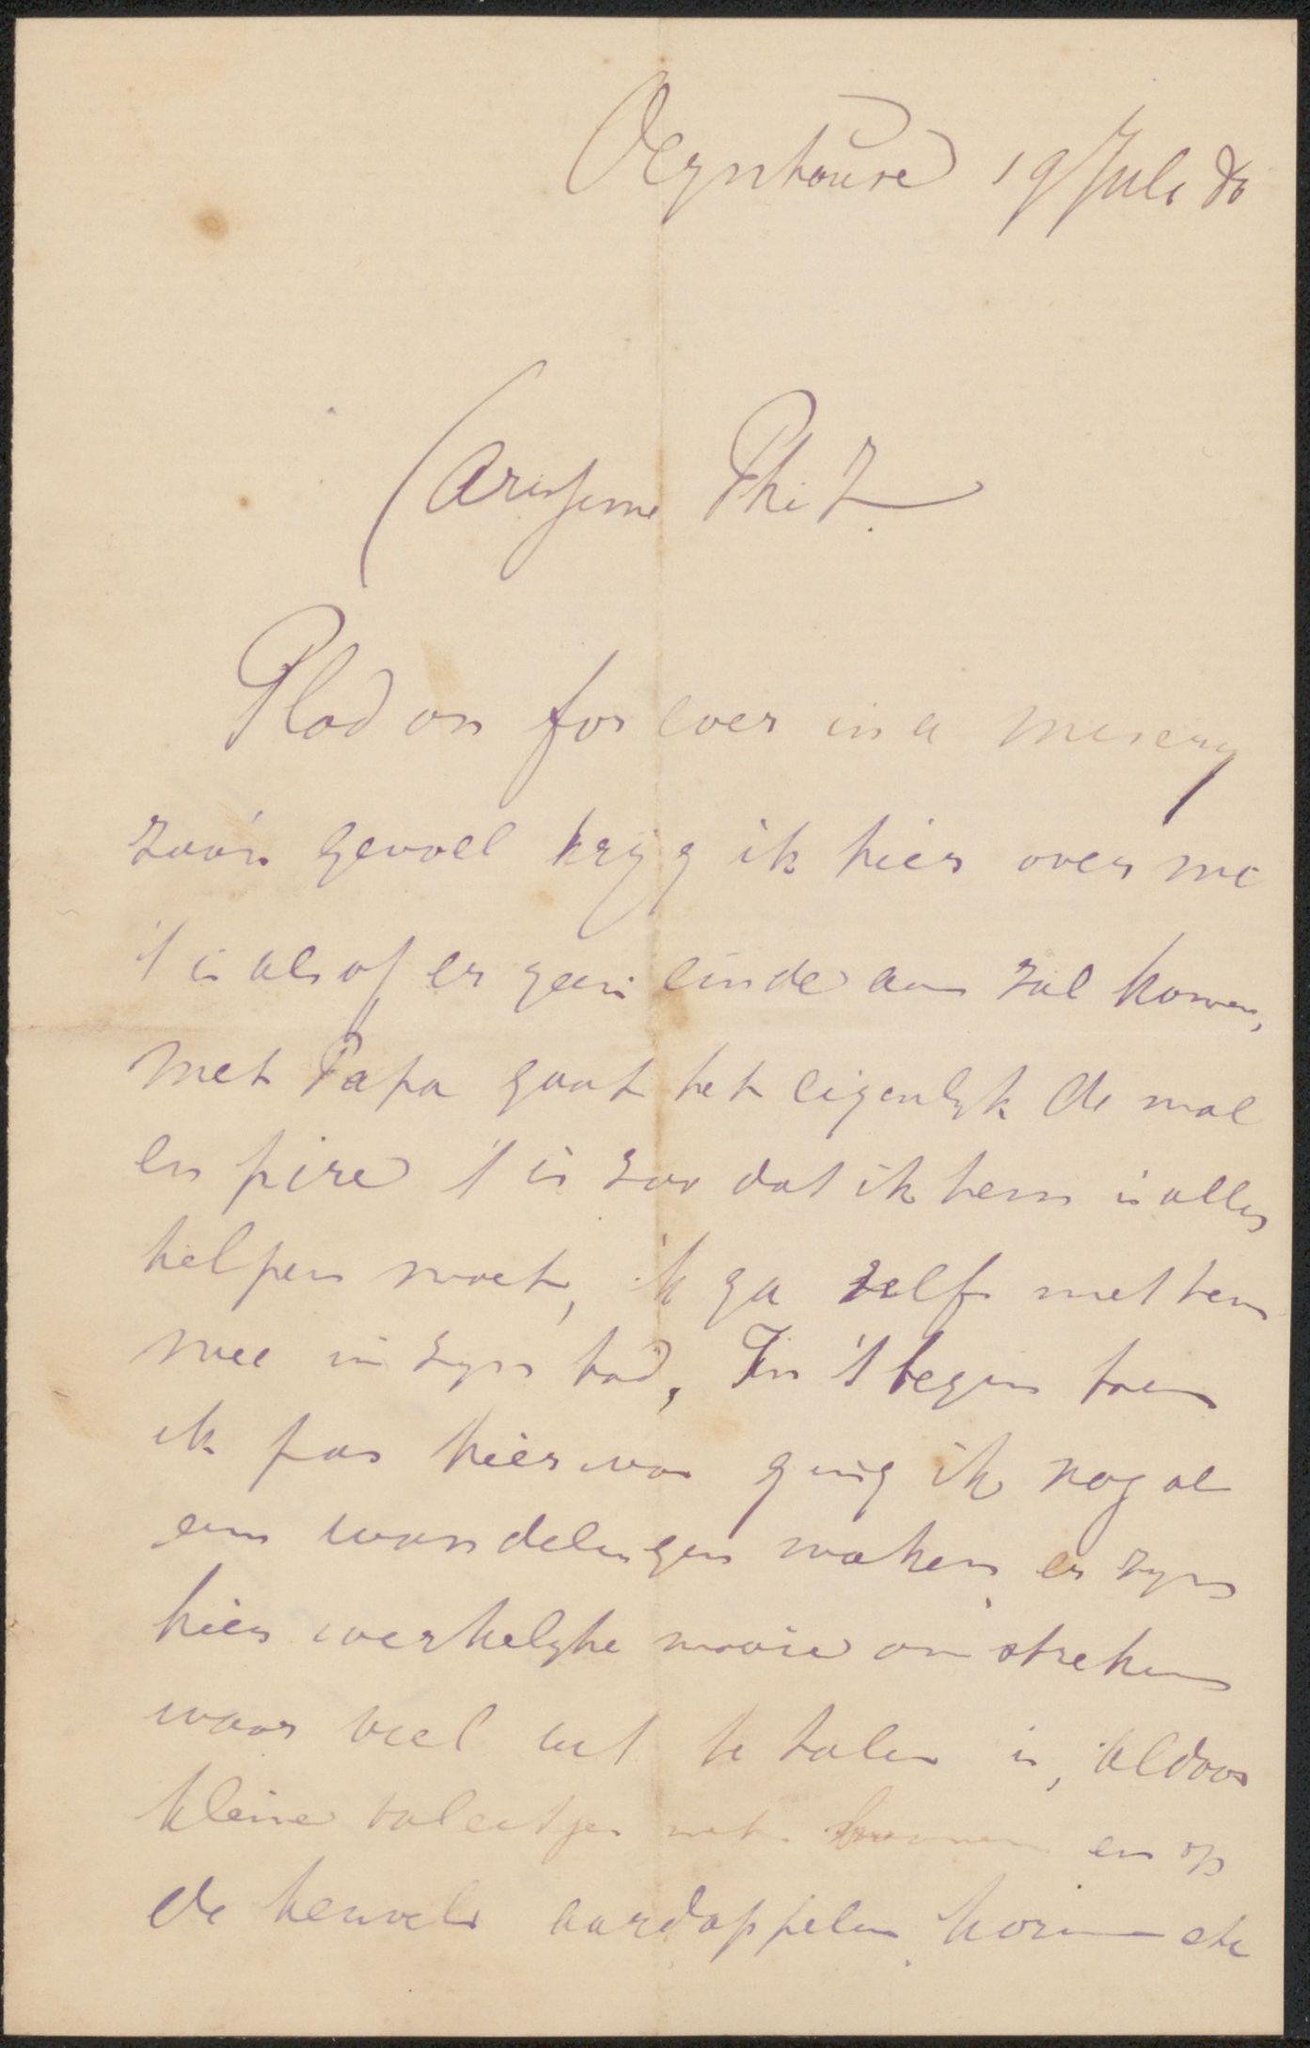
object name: letter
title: Brief aan Philip Zilcken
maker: adriaan pit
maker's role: print maker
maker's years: 1860-1944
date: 1880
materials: ink, paper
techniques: pen, writing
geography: the hague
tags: painter, draughtsman, philip zilcken, passions, emotions, affections, literature ~ arts, the hague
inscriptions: collector's mark: ‘RPK’